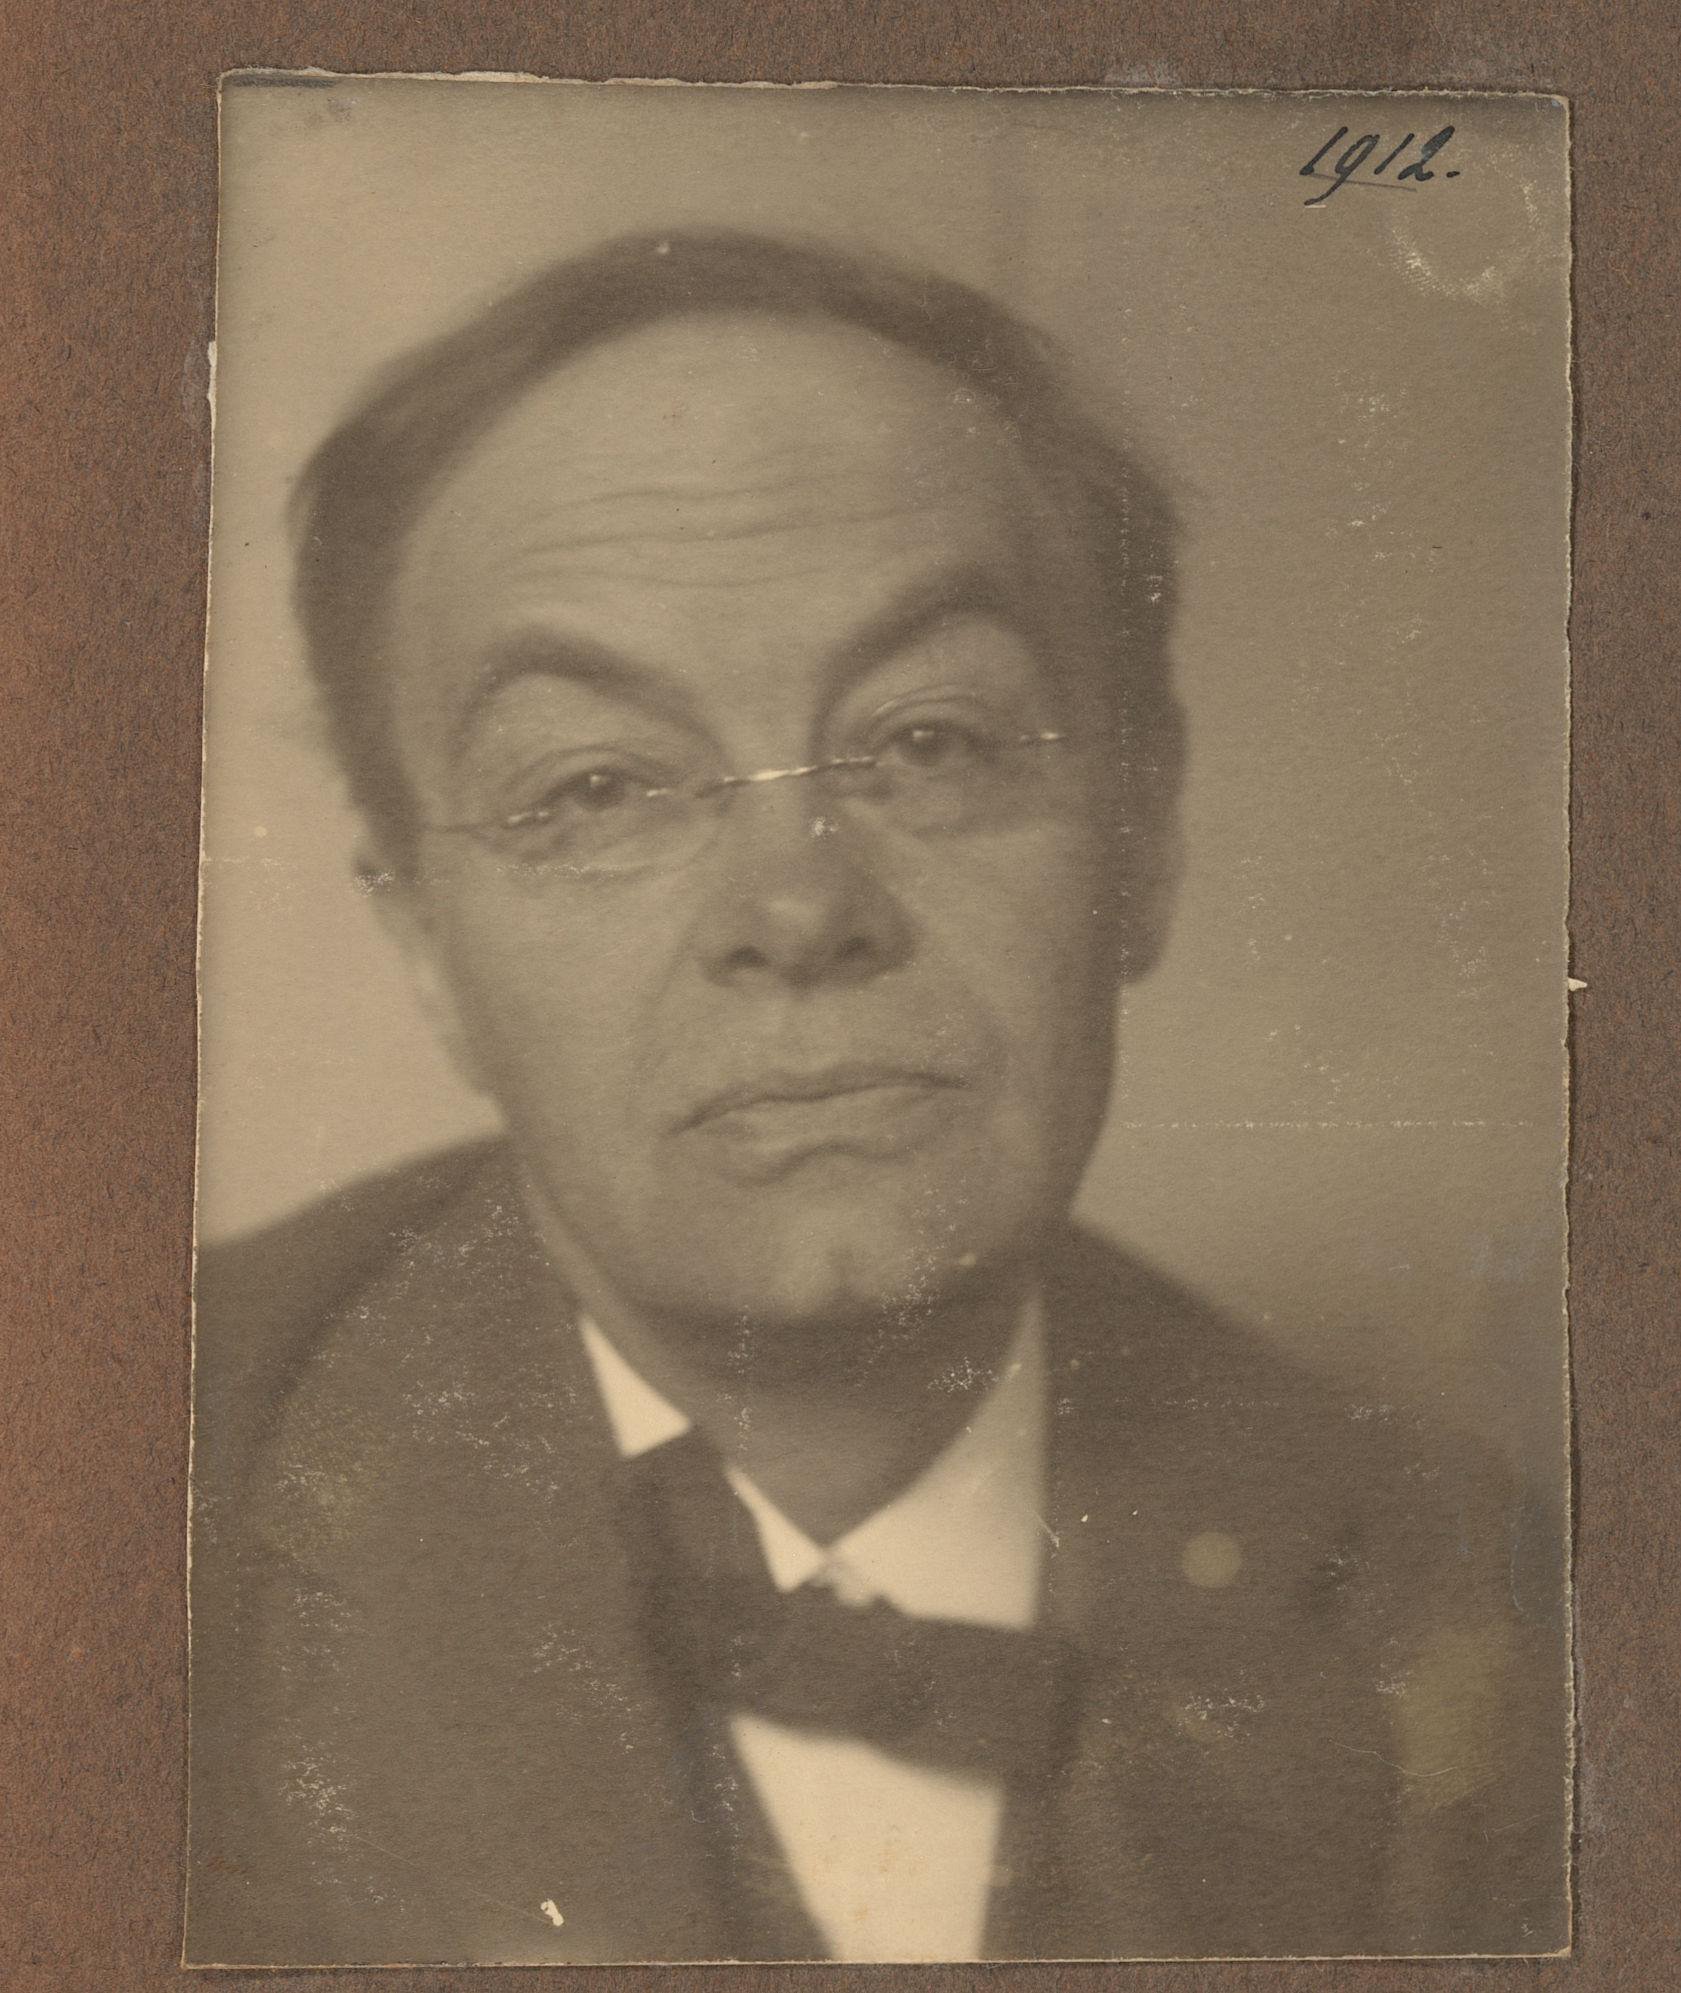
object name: photograph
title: Portret van Alphons Diepenbrock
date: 1911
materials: photographic support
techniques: daylight paper print, pasting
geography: amsterdam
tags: alphons diepenbrock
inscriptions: date: ‘1912.’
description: Foto op bruin albumblad 10 van familiealbum van Alphons Diepenbrock.